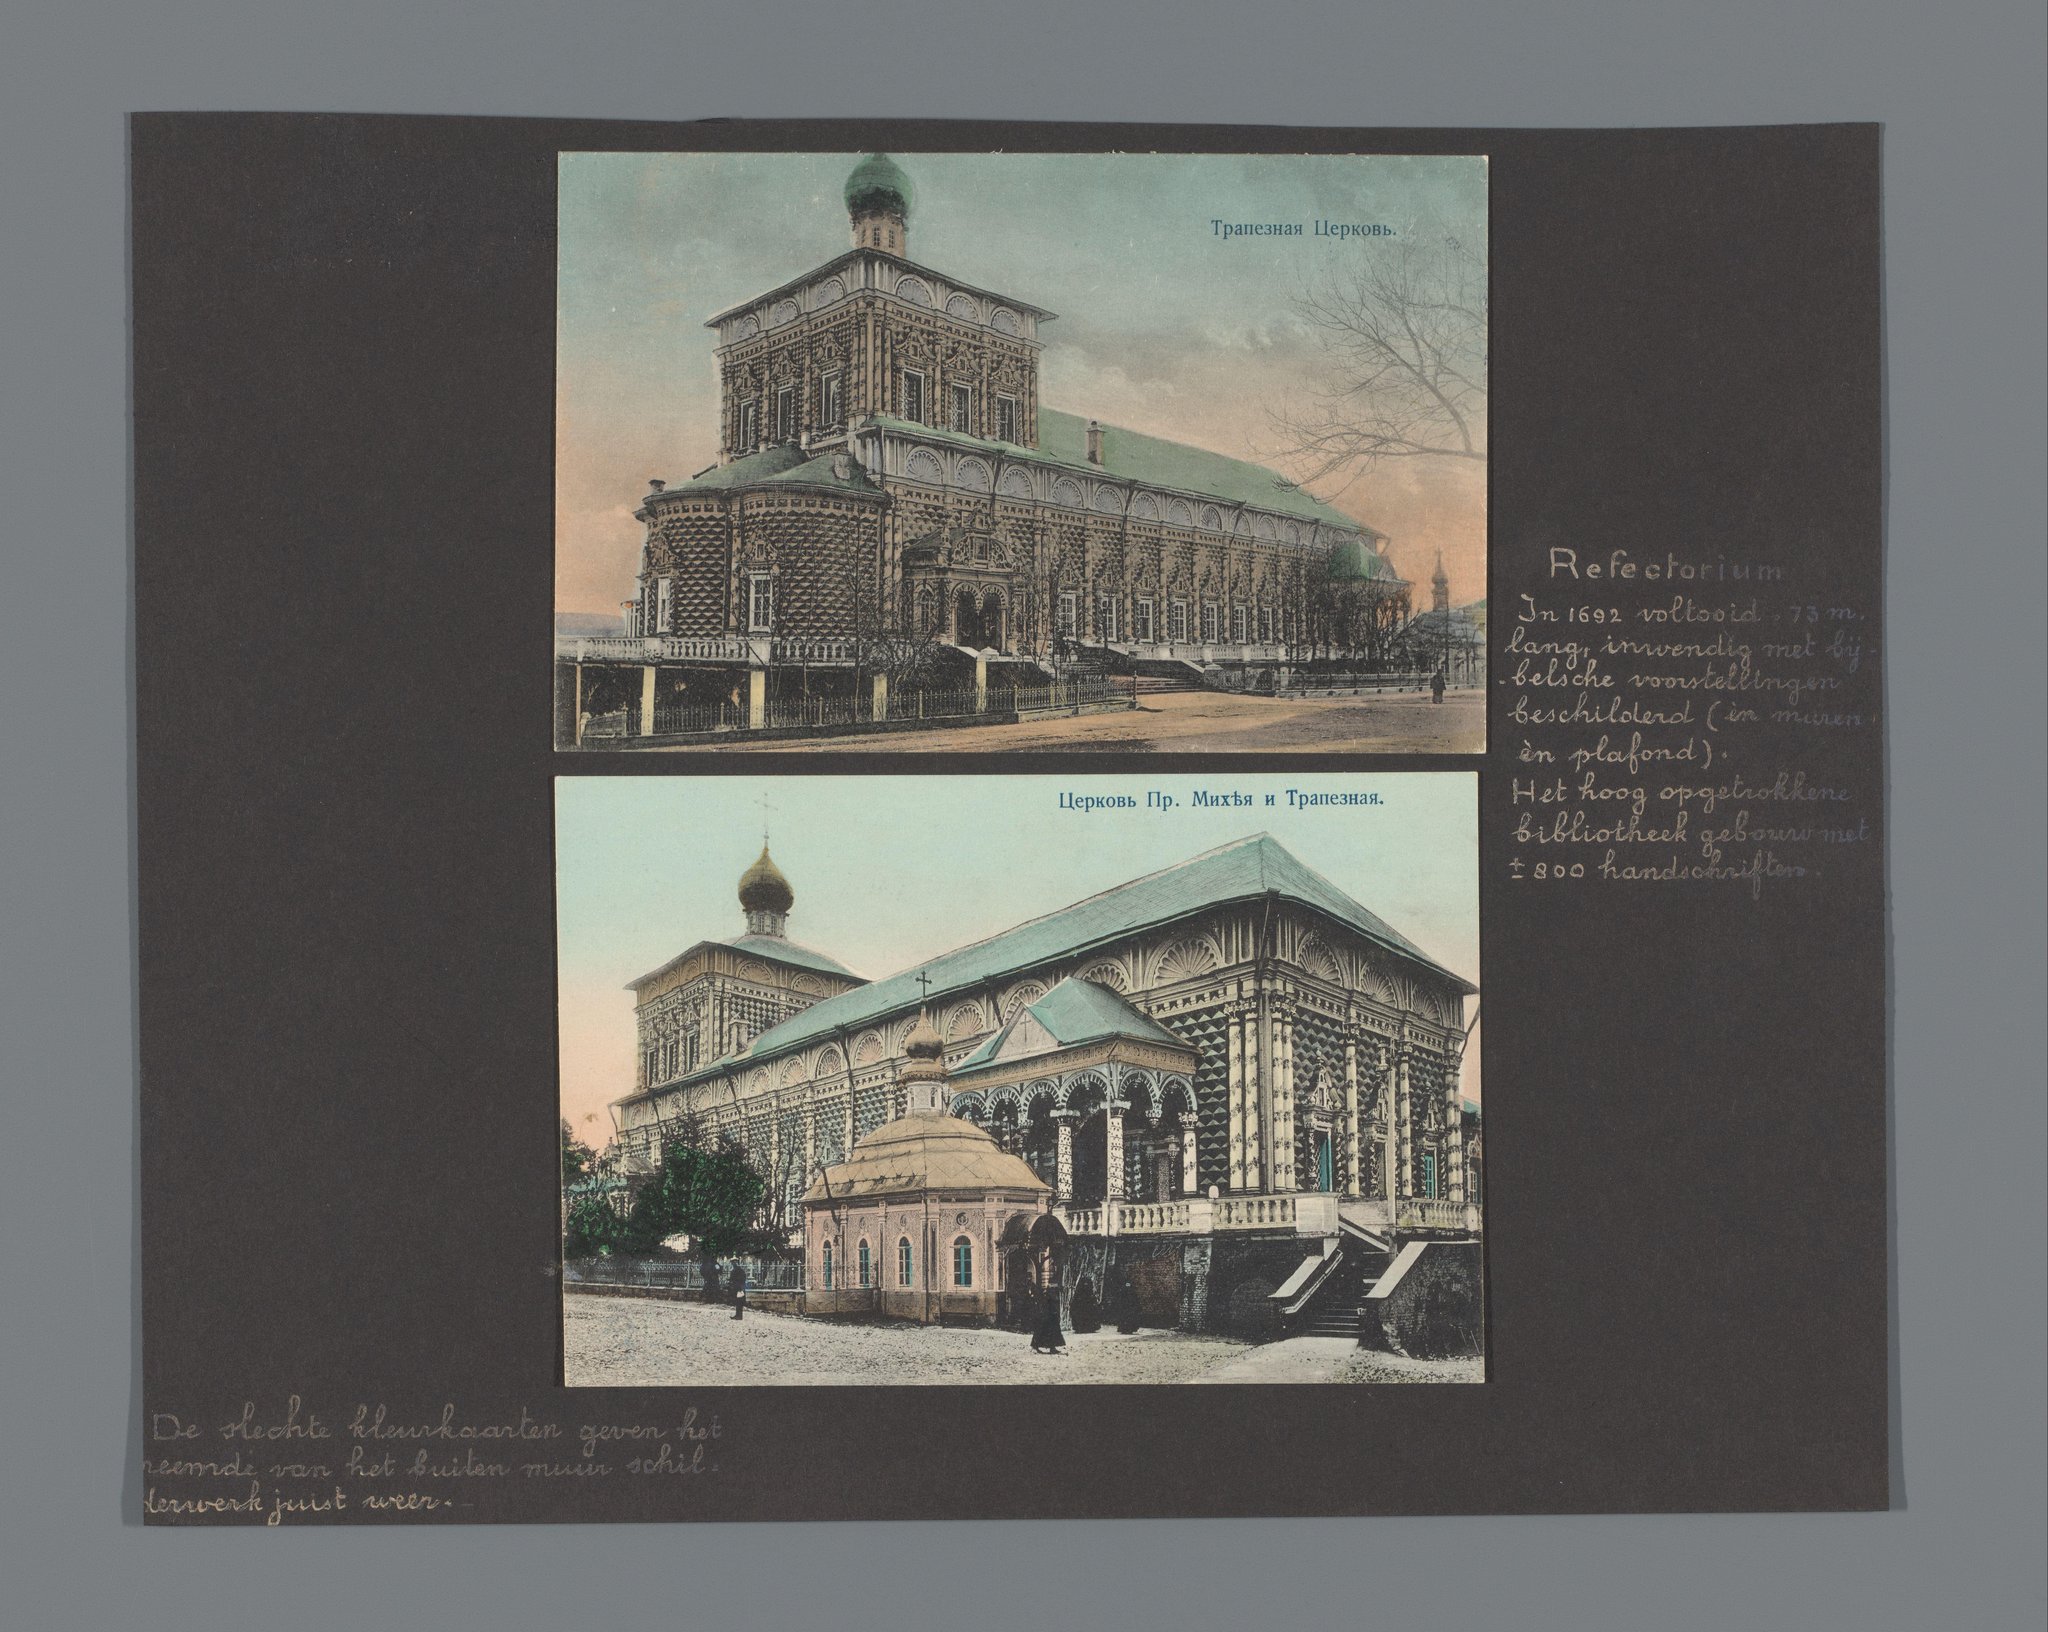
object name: photograph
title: Refectorium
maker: Anonymous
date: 1860-1925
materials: photographic support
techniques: photograph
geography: russia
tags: russia